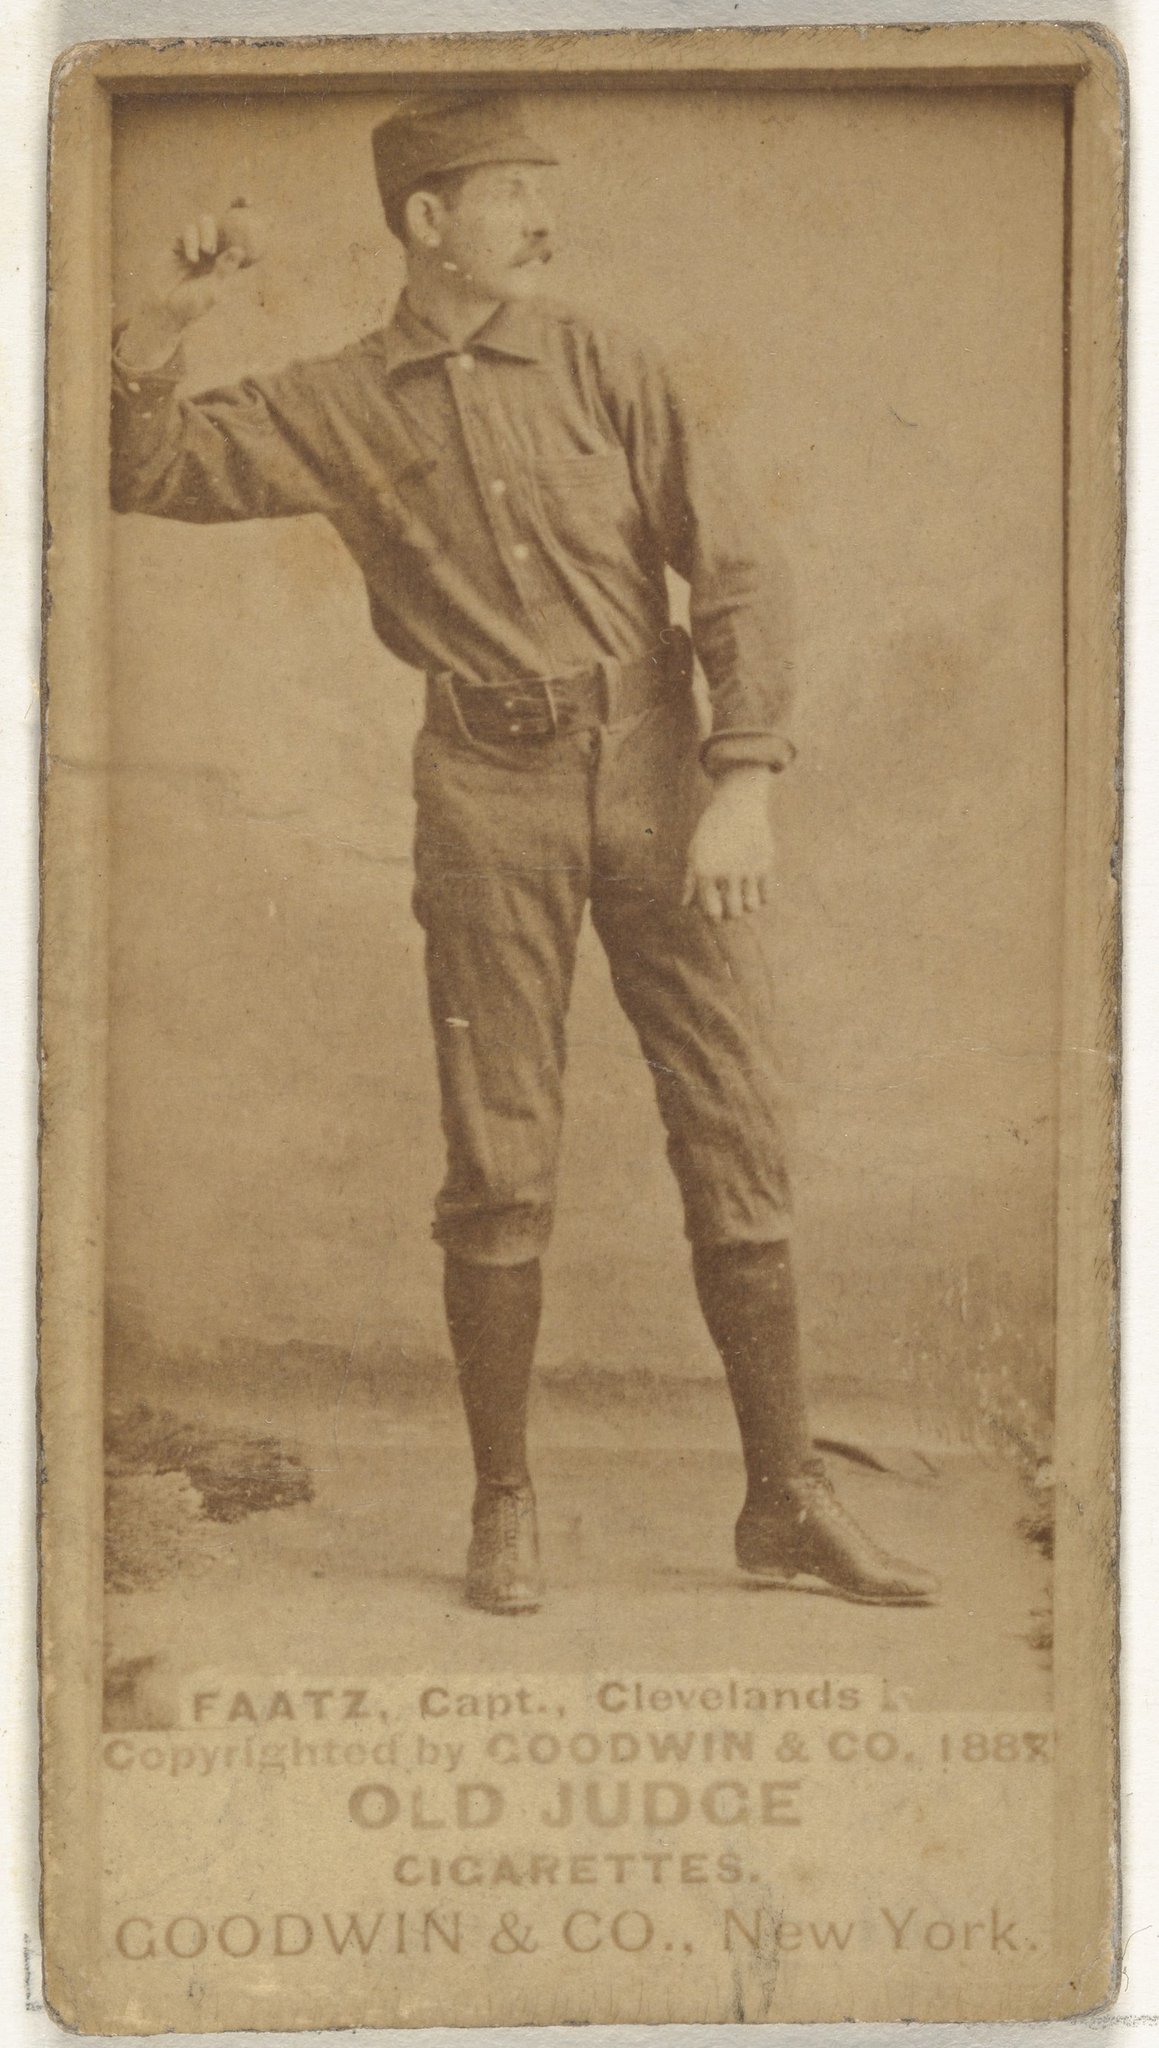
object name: baseball card, photograph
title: Jayson S. "Jay" Faatz, Captain, Cleveland, from the Old Judge series (N172) for Old Judge Cigarettes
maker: goodwin & company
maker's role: publisher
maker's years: 1850-1950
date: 1888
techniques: albumen silver print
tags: men,portraits,baseball,athletes